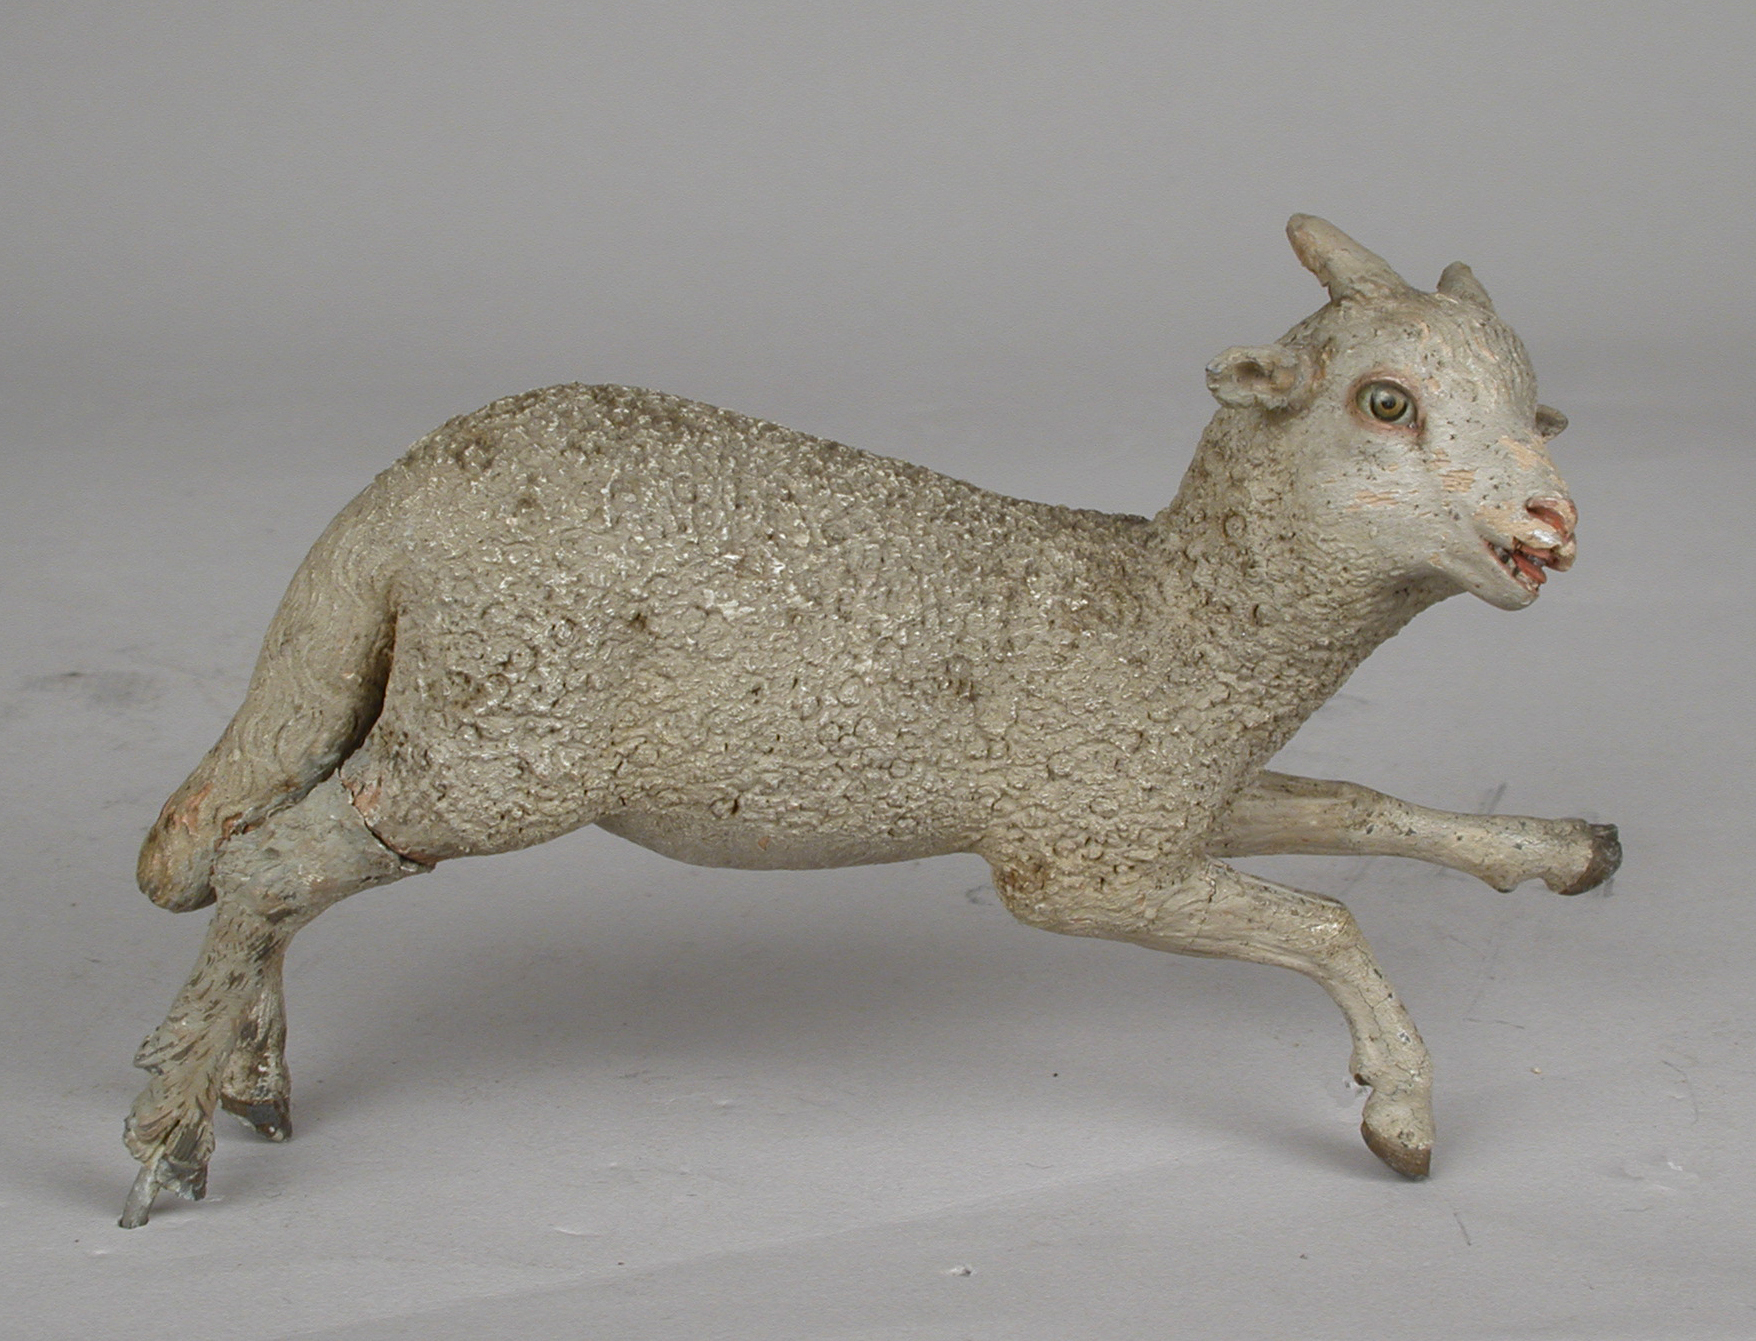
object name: crèche figure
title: Lamb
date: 1751-1800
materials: lead, terracotta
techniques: polychrome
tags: lambs